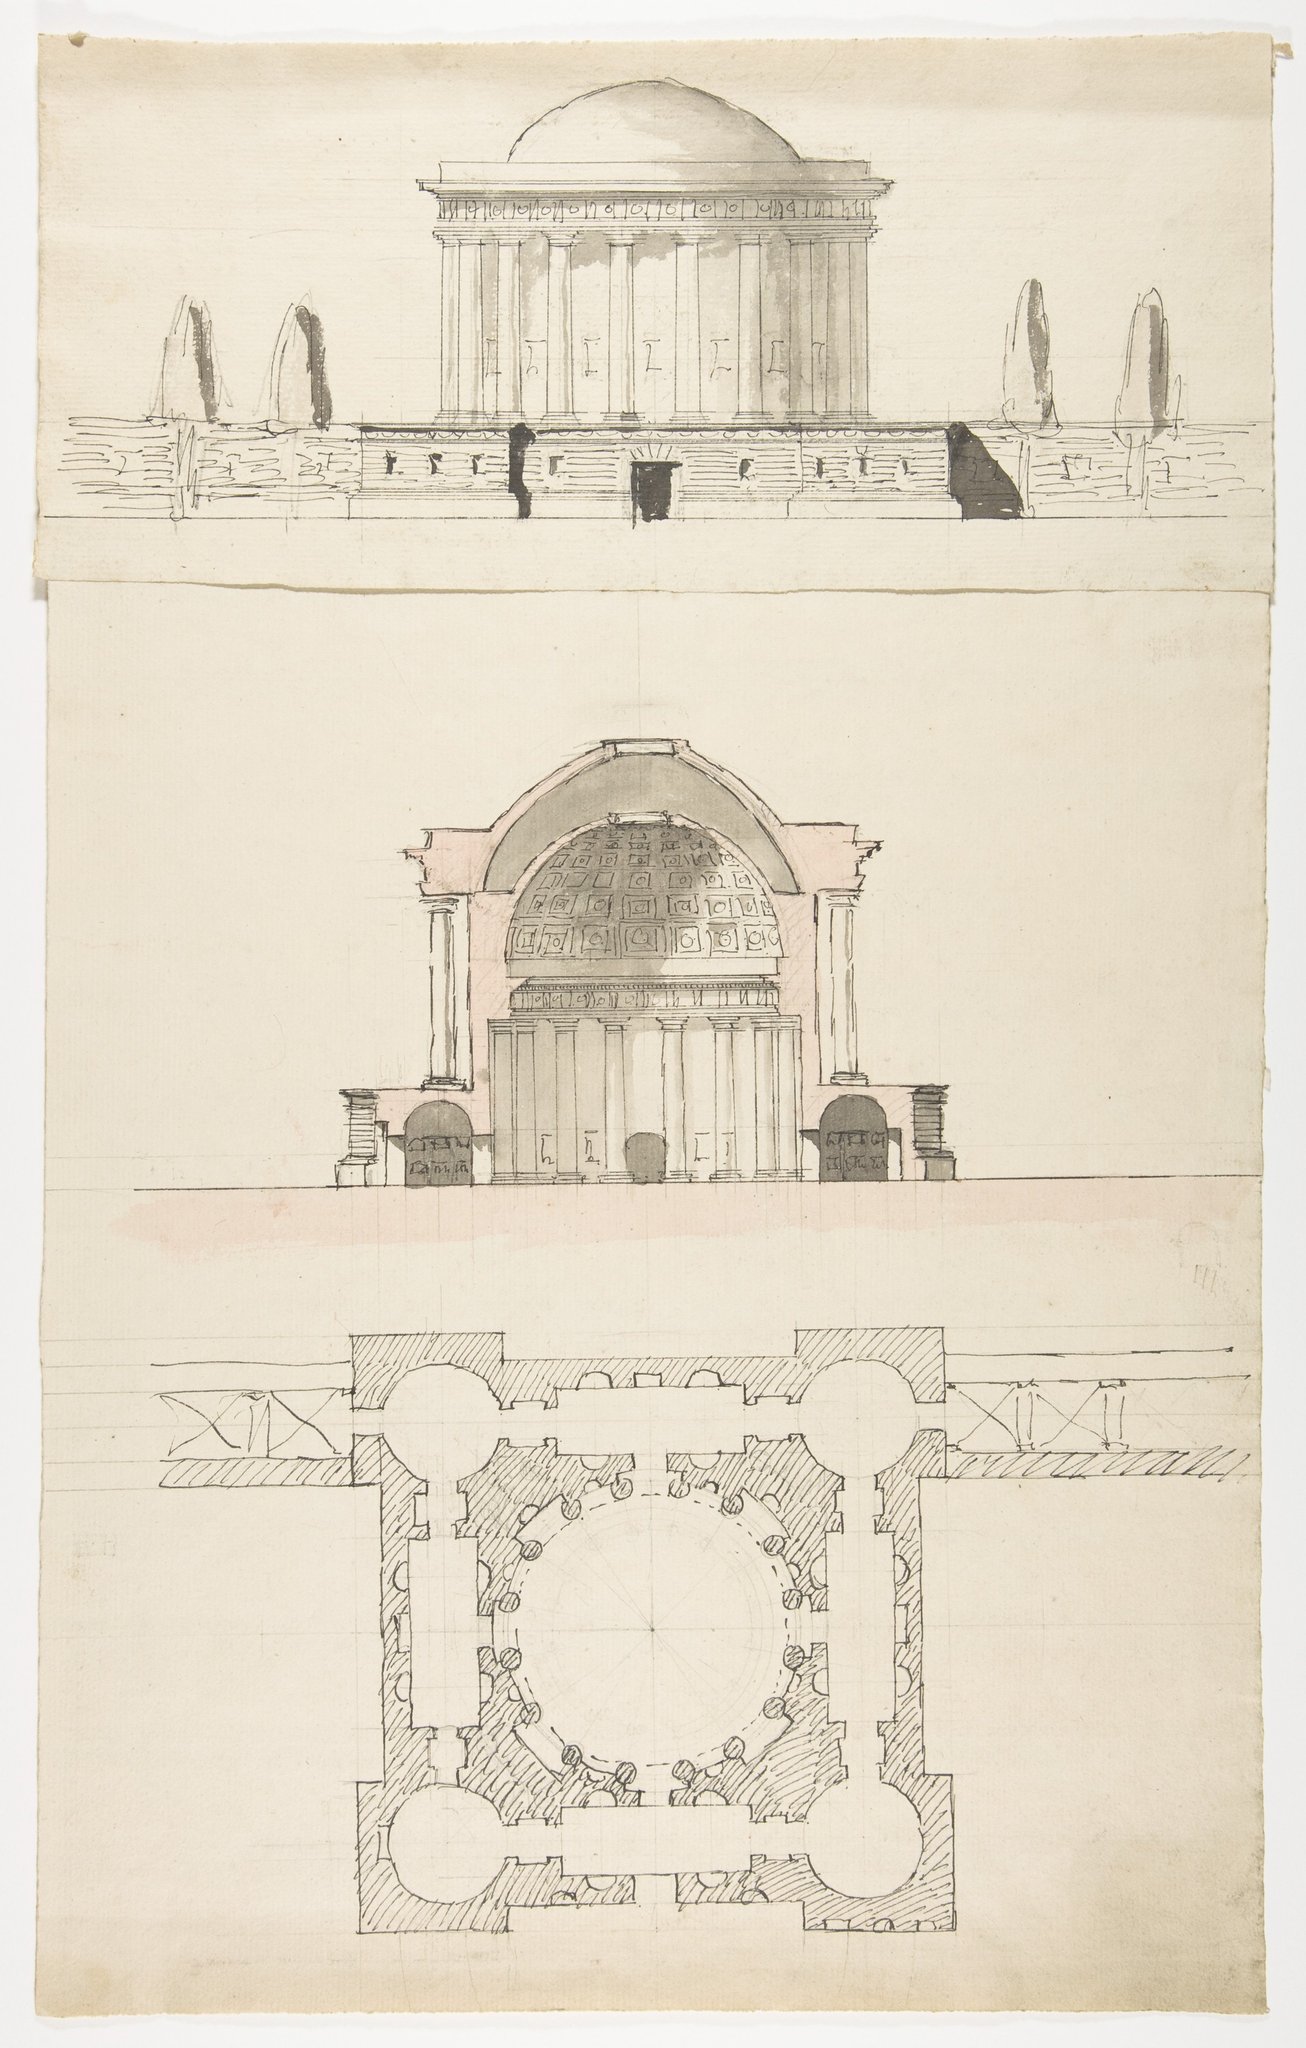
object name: drawing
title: Architectural Drawing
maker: nicolas françois barbier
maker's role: artist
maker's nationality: french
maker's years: 1768-1826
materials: graphite, ink, paper, watercolor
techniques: pen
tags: architecture